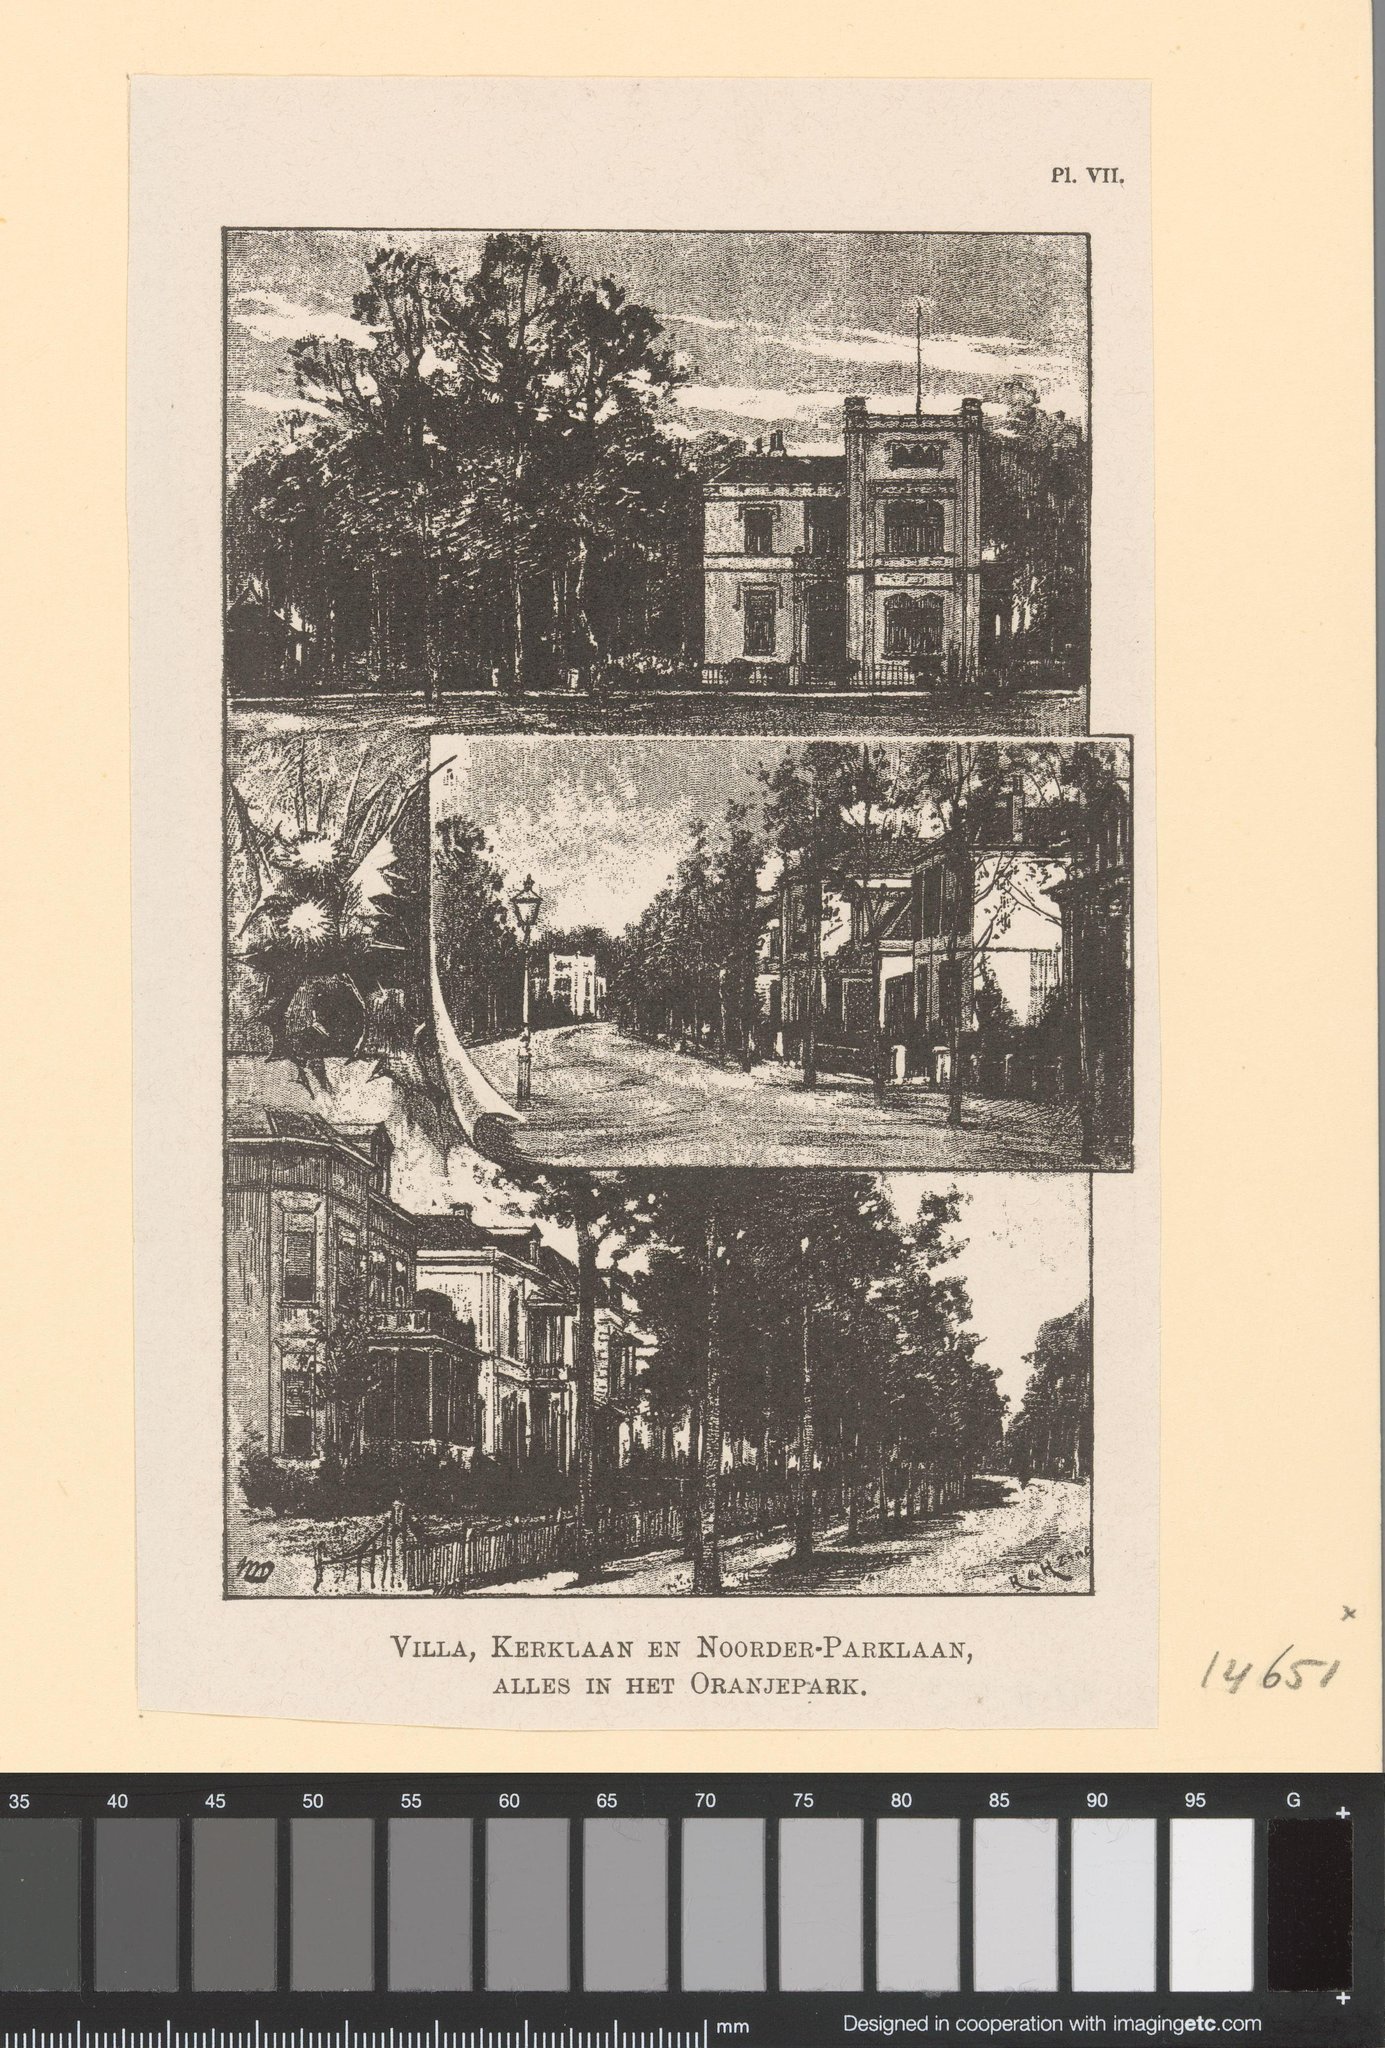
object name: photomechanical print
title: Gezichten op Apeldoorn en omstreken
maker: Anonymous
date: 1890-1900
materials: paper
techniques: autotype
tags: fish pond (in garden), villa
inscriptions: monogram, monogram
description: Prent mogelijk uit: Gids voor Apeldoorn en omstreken. Apeldoorn: Vereeniging tot veraangenaming van het verblijf te Apeldoorn, [1891-1897].